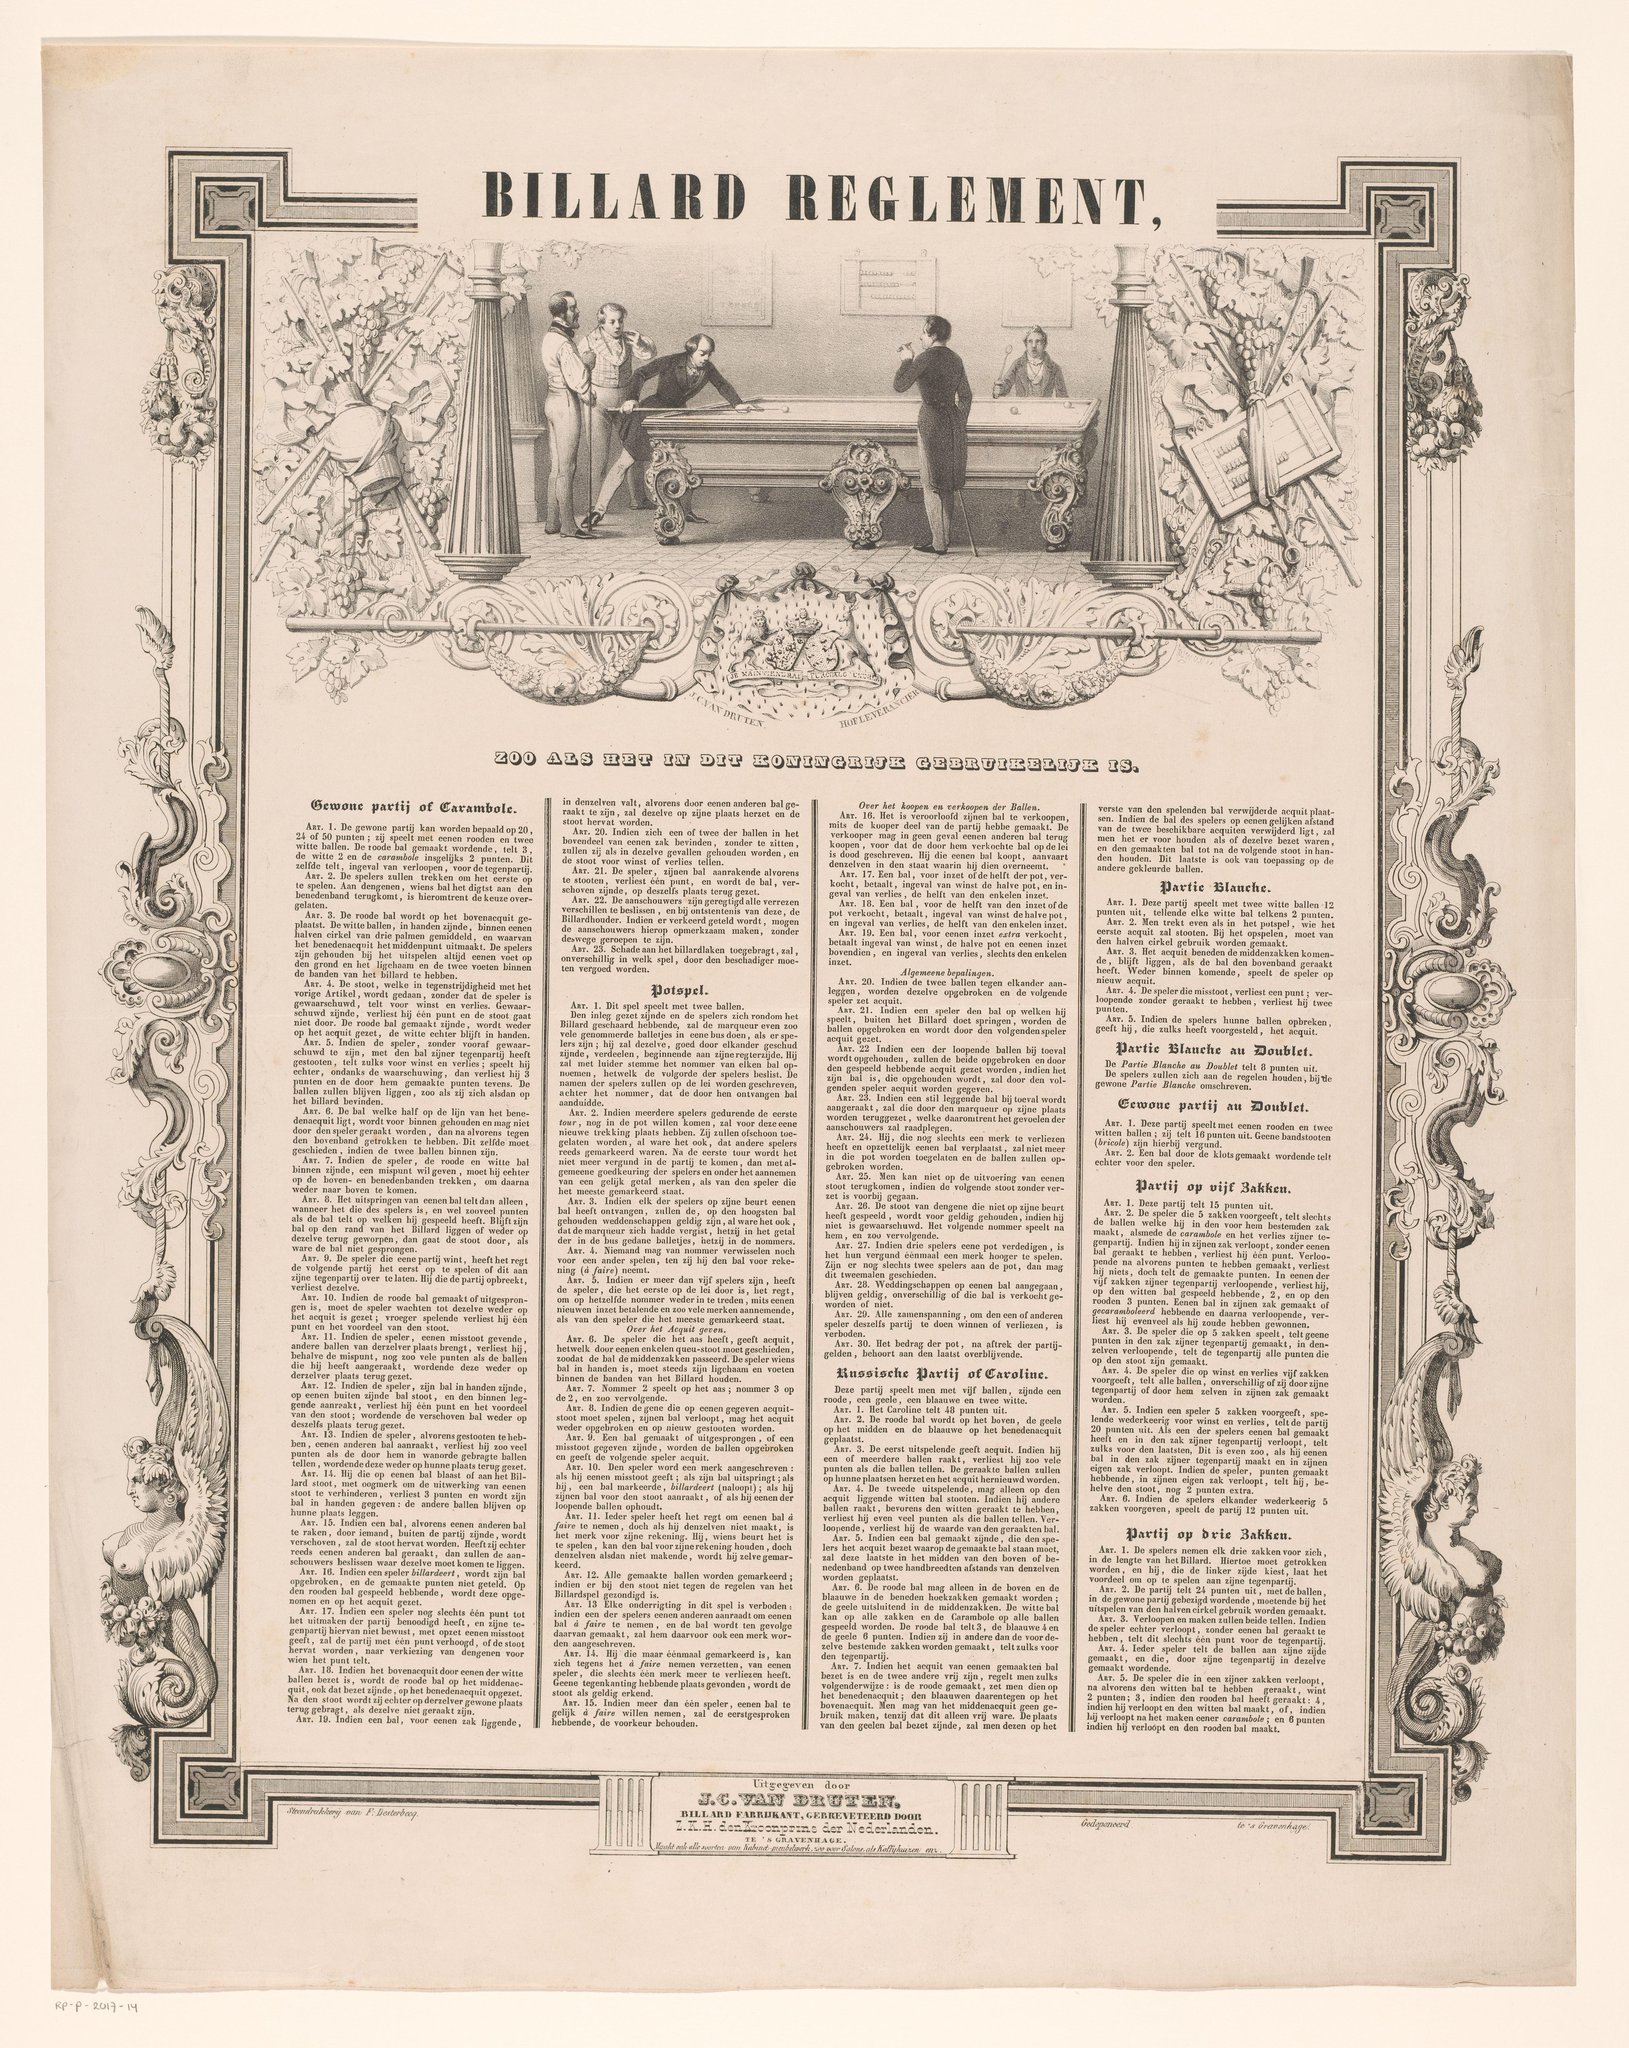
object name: print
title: Mannen bij een biljarttafel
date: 1842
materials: paper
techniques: letterpress printing, lithograph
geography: the hague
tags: billiards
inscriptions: : ‘Gedeponeerd.’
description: Bovenin vijf mannen aan een biljarttafel. Links en rechts daarvan attributen die verwijzen naar de biljartsport. Daaronder een regelement in boekdruk.